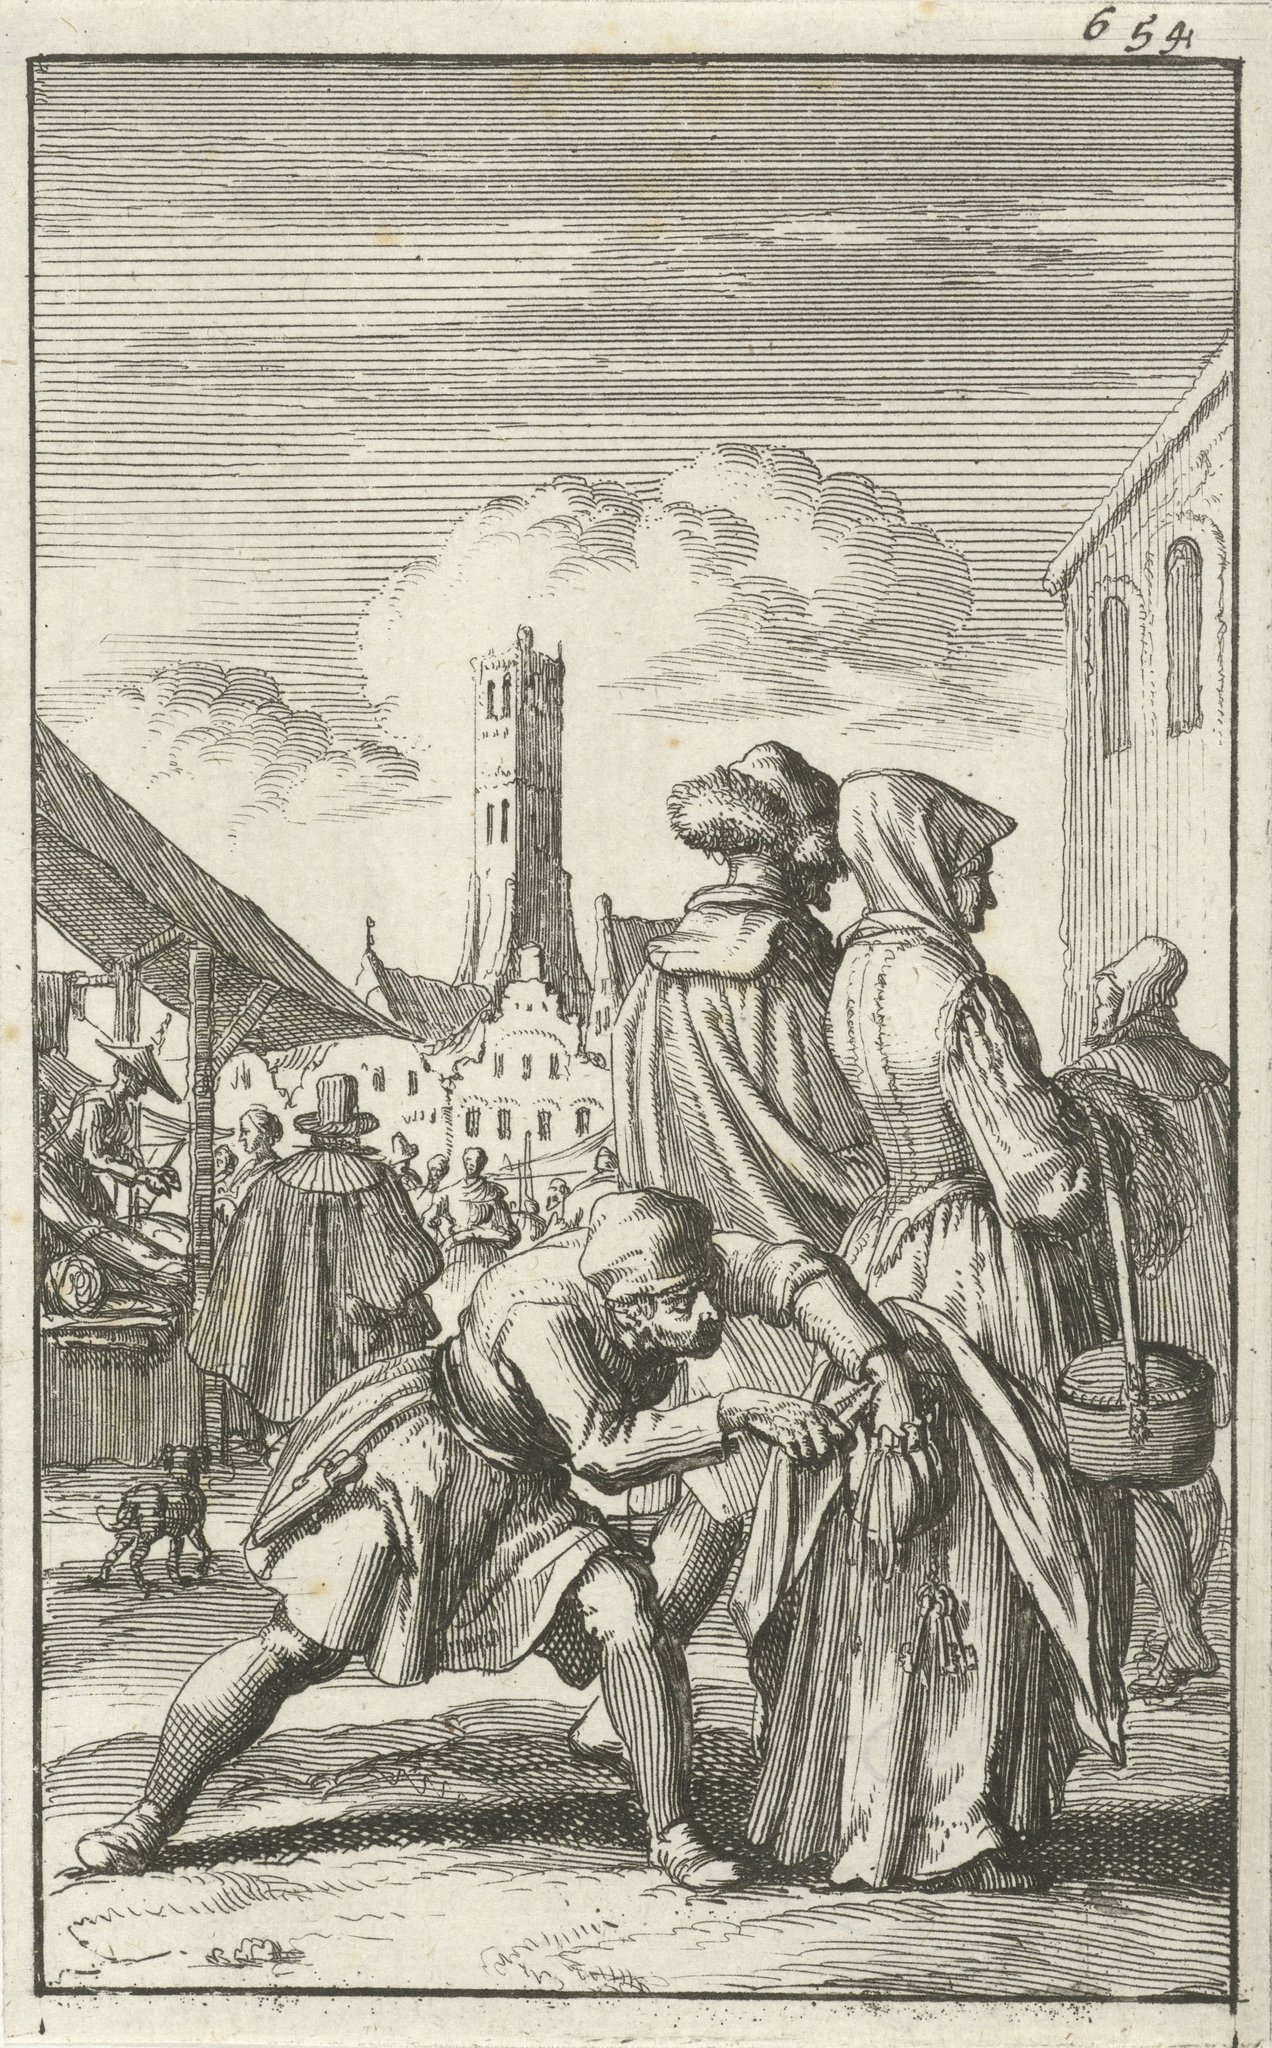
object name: book illustration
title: Vrouw op een jaarmarkt door een dief van haar geldbuidel beroofd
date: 1685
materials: paper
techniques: etching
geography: amsterdam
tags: pickpocket, market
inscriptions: collector's mark: Lugt 2228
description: Illustratie uit: Hondorffius, Andreas. De tien geboden des Heeren. Amsterdam: Jan Bouman, 1685.